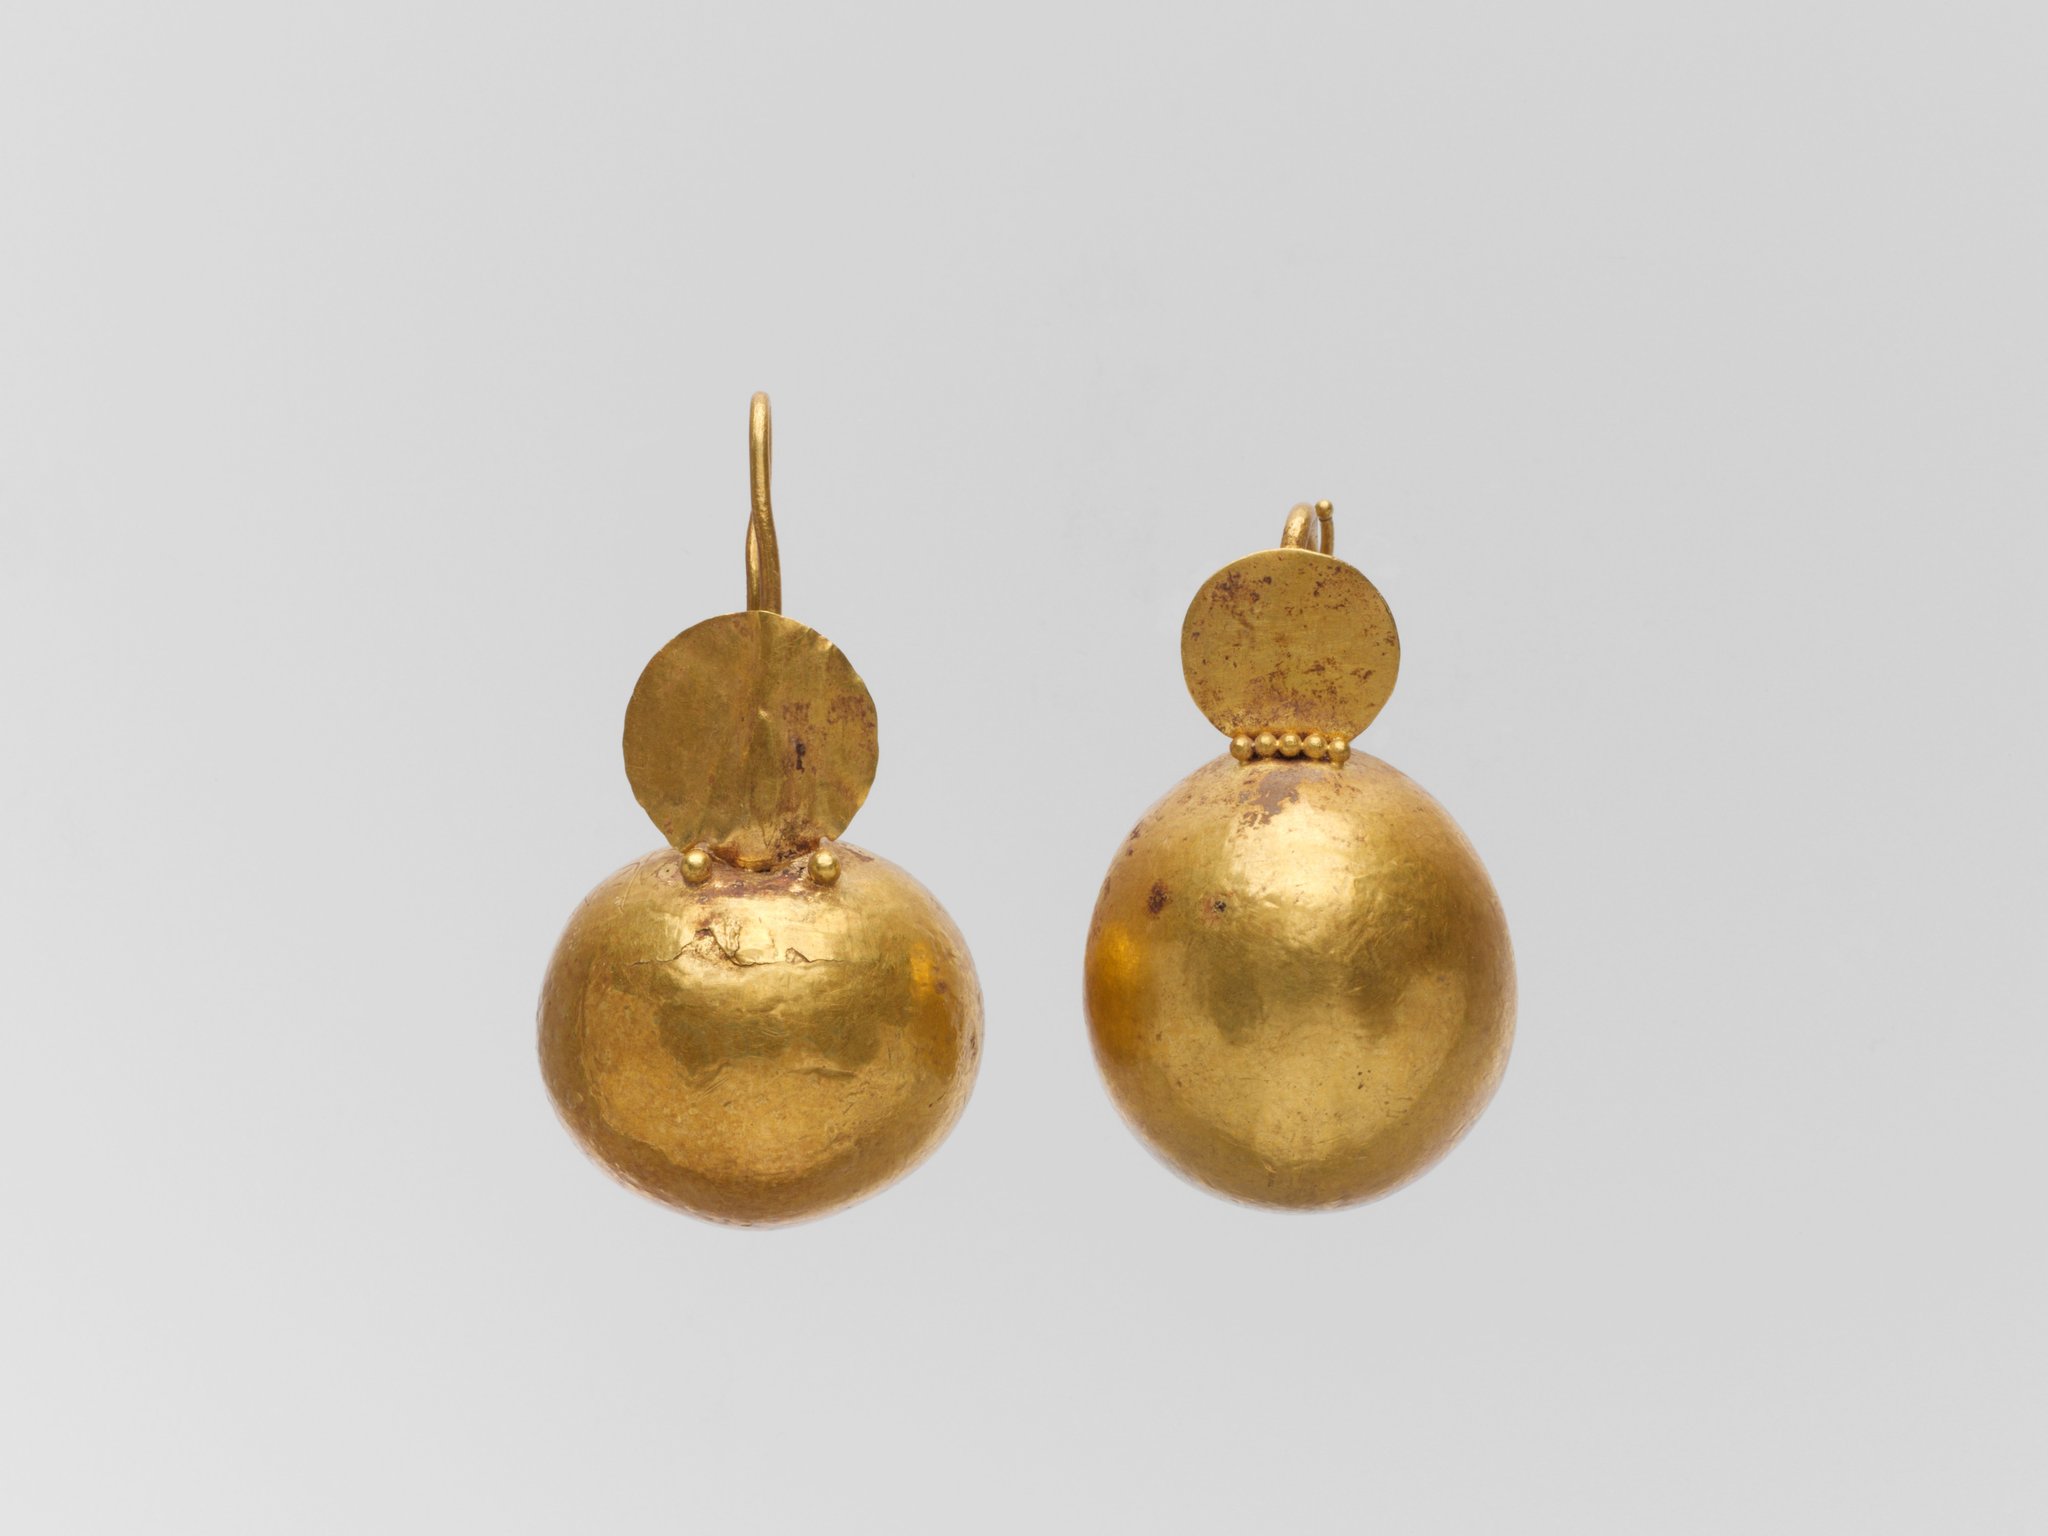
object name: earring hook type with disc of thin foil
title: Gold earring with convex disk and small disk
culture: roman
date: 1-200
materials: gold